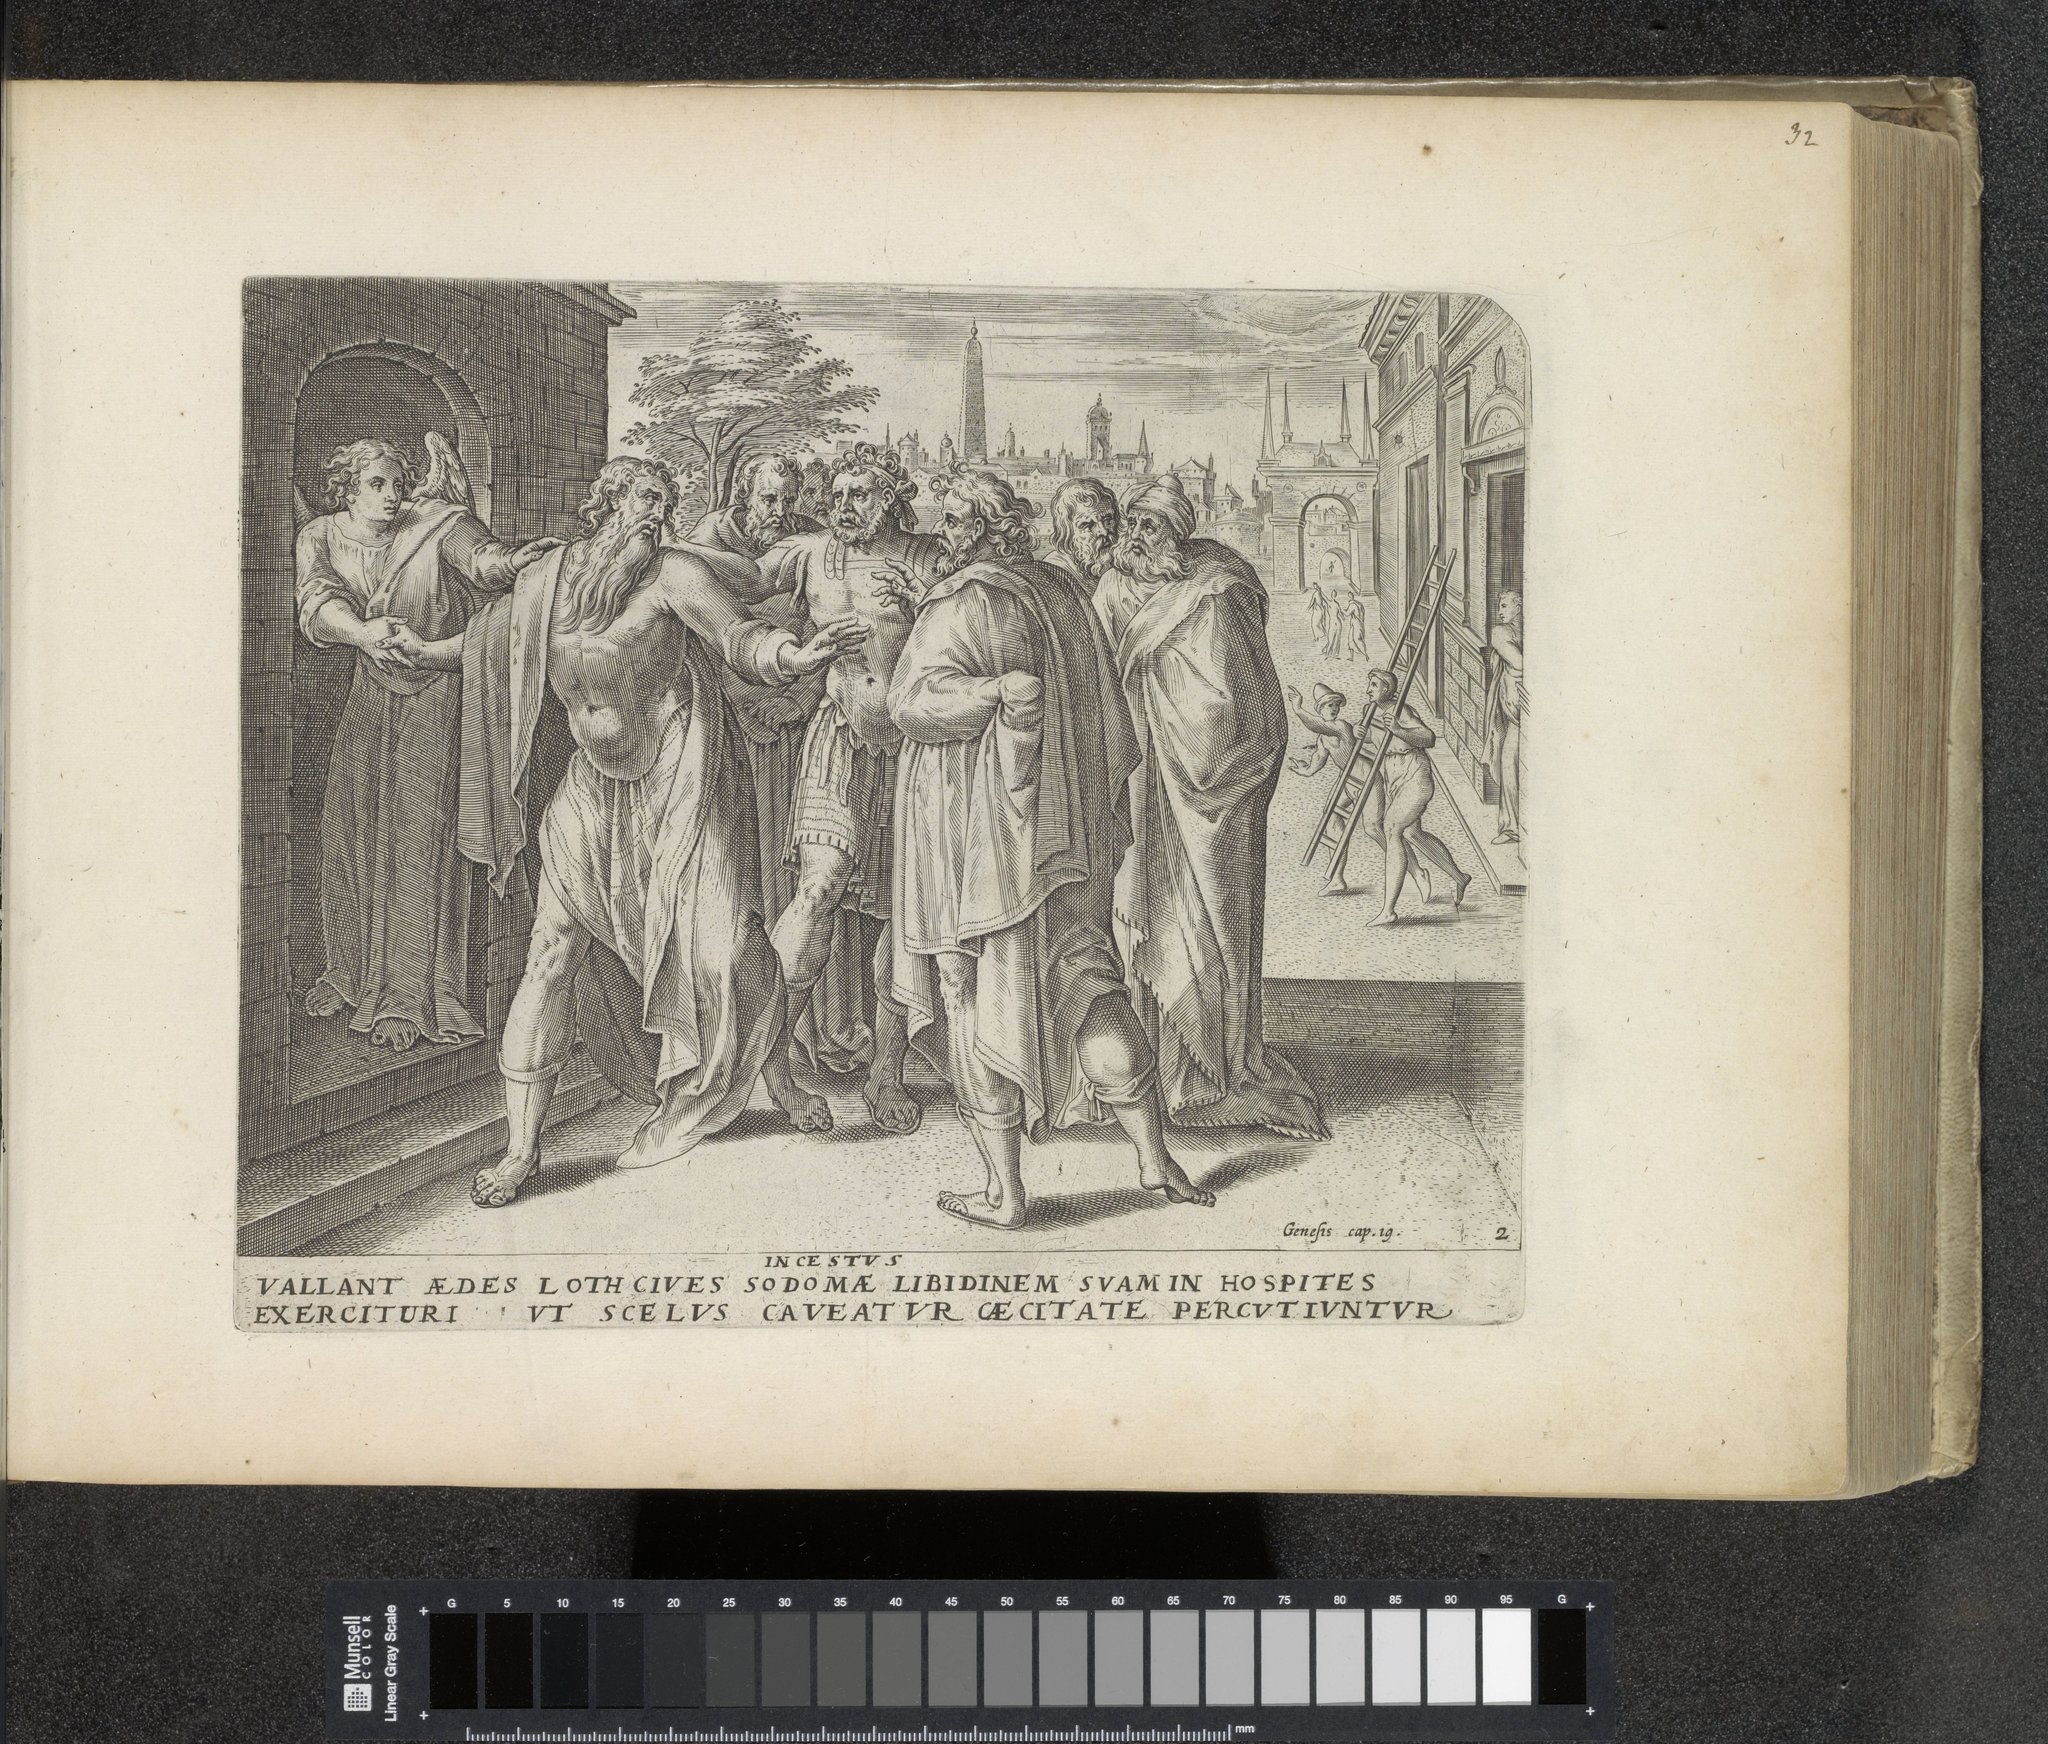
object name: print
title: Incestus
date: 1579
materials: paper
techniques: engraving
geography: amsterdam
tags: lot tries to pacify the mob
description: Voor de deur van zijn huis probeert Lot de mannen uit Sodom tot kalmte te manen. De mannen verzoeken hem om zijn gasten naar buiten te laten, zodat zij ze kunnen nemen. Een van de engelen trekt Lot naar binnen. Onder de voorstelling een verwijzing in het Latijn naar de Bijbeltekst in Gen. 19. Deze prent maakt deel uit van een album.